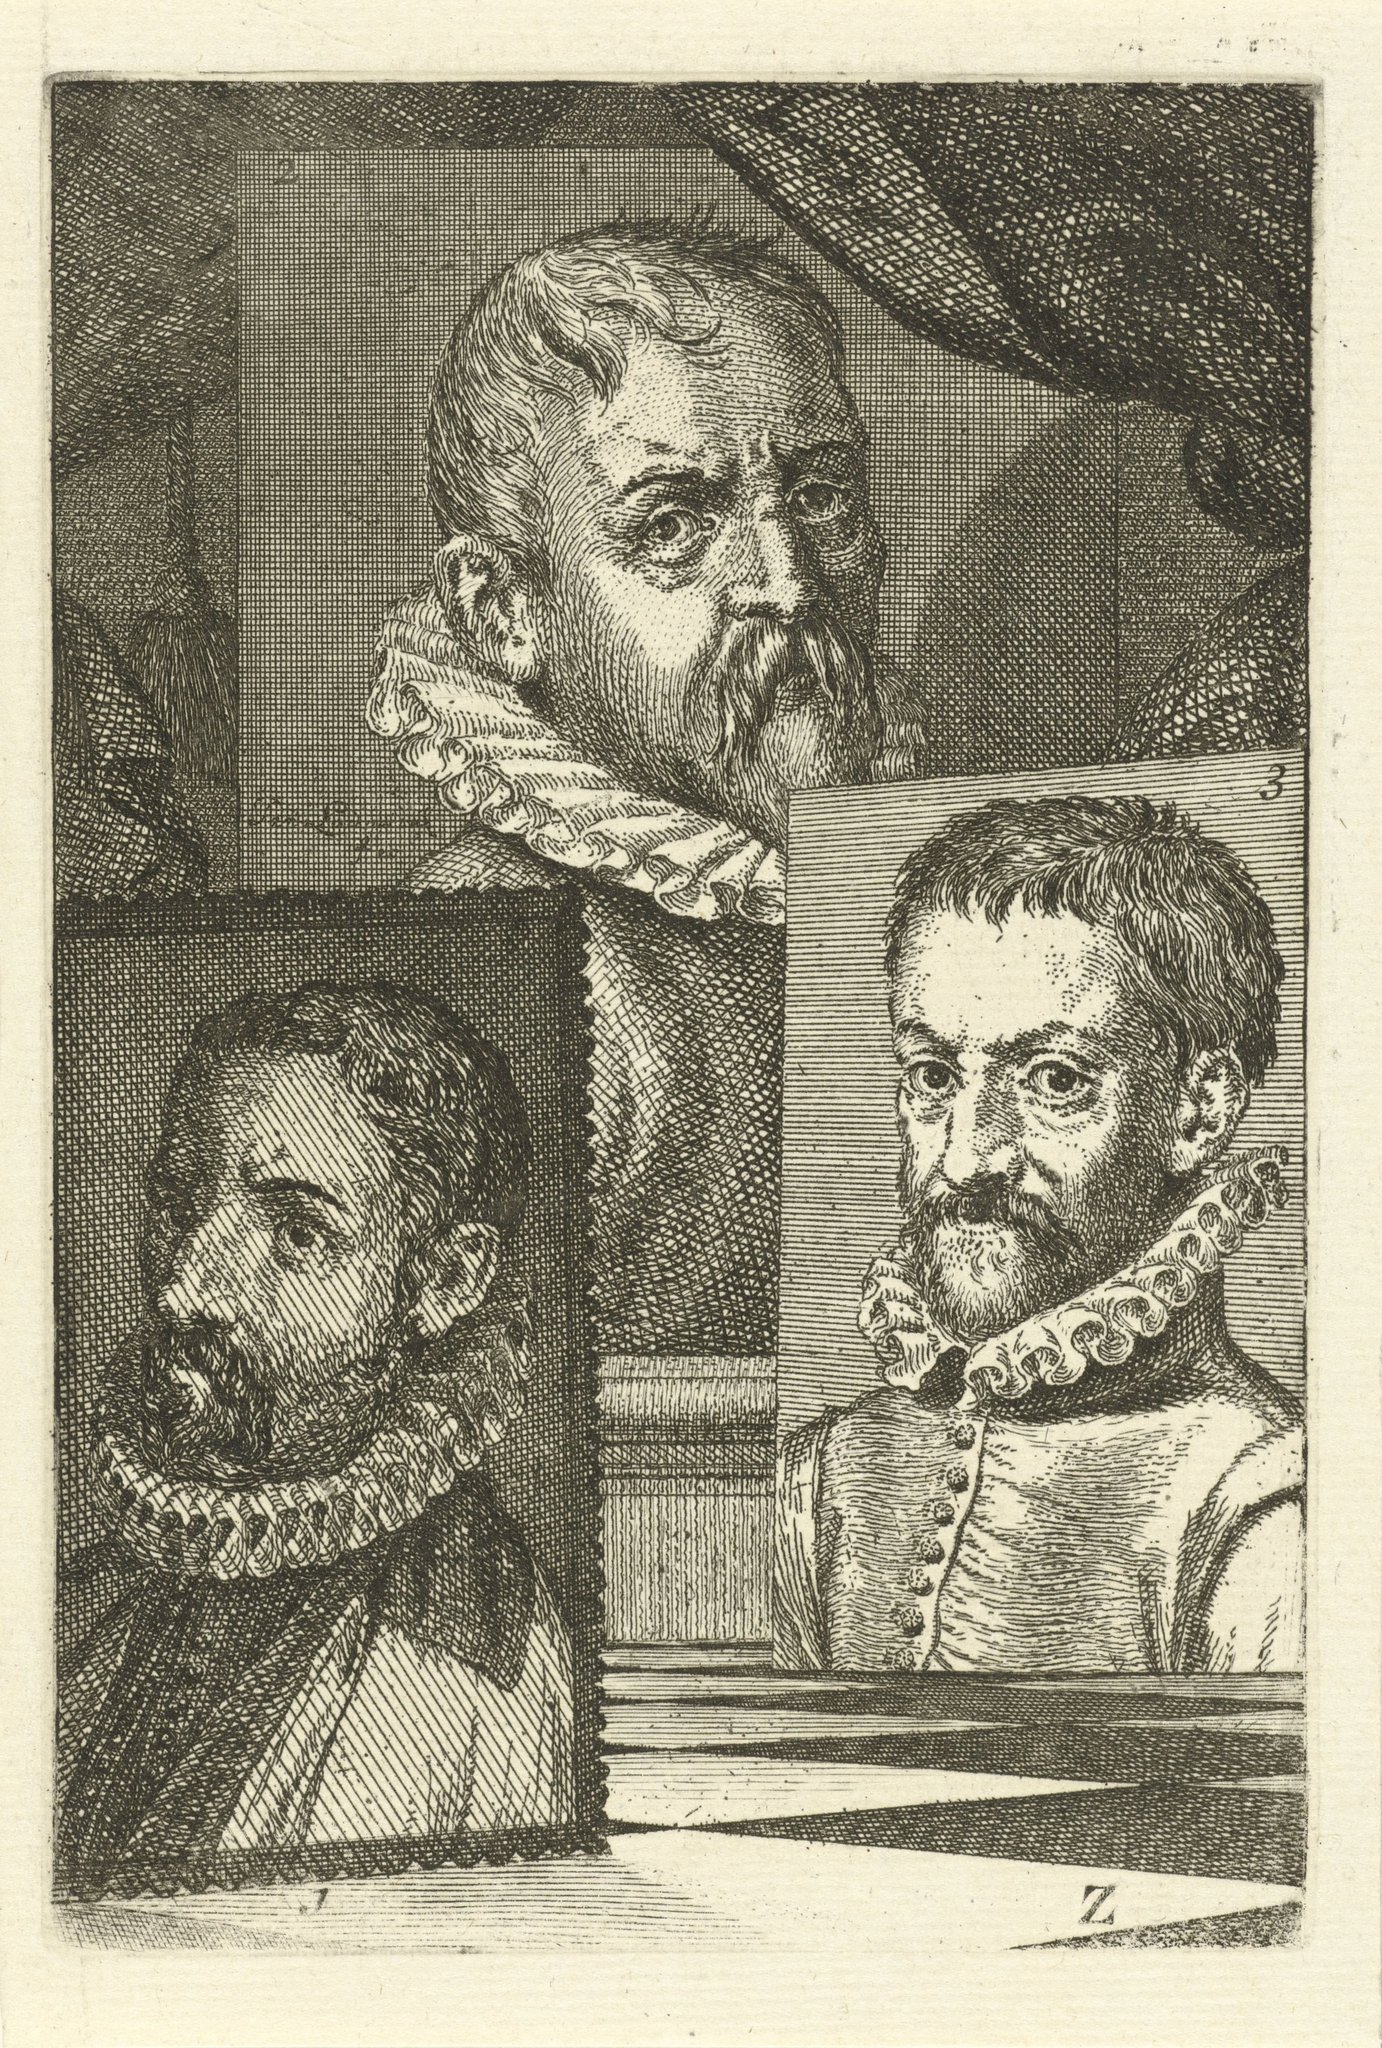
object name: book illustration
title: Portretten van Anthonie Blocklandt, Dirck Barendsz. en Dominicus Lampsonius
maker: jan l admiral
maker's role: draughtsman, print maker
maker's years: 1699-1773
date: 1764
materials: paper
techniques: etching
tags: bruges, liège, draughtsman, dominicus lampsonius, amsterdam, dirck barendsz., utrecht, anthonie blocklandt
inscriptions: collector's mark: Lugt 2228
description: Prent opgenomen in: Mander, Karel van; Jongh, Jacobus de (vert.). Het leven der doorluchtige Nederlandsche en eenige Hoogduitsche schilders. Amsterdam: Steven van Esveldt, 1764.